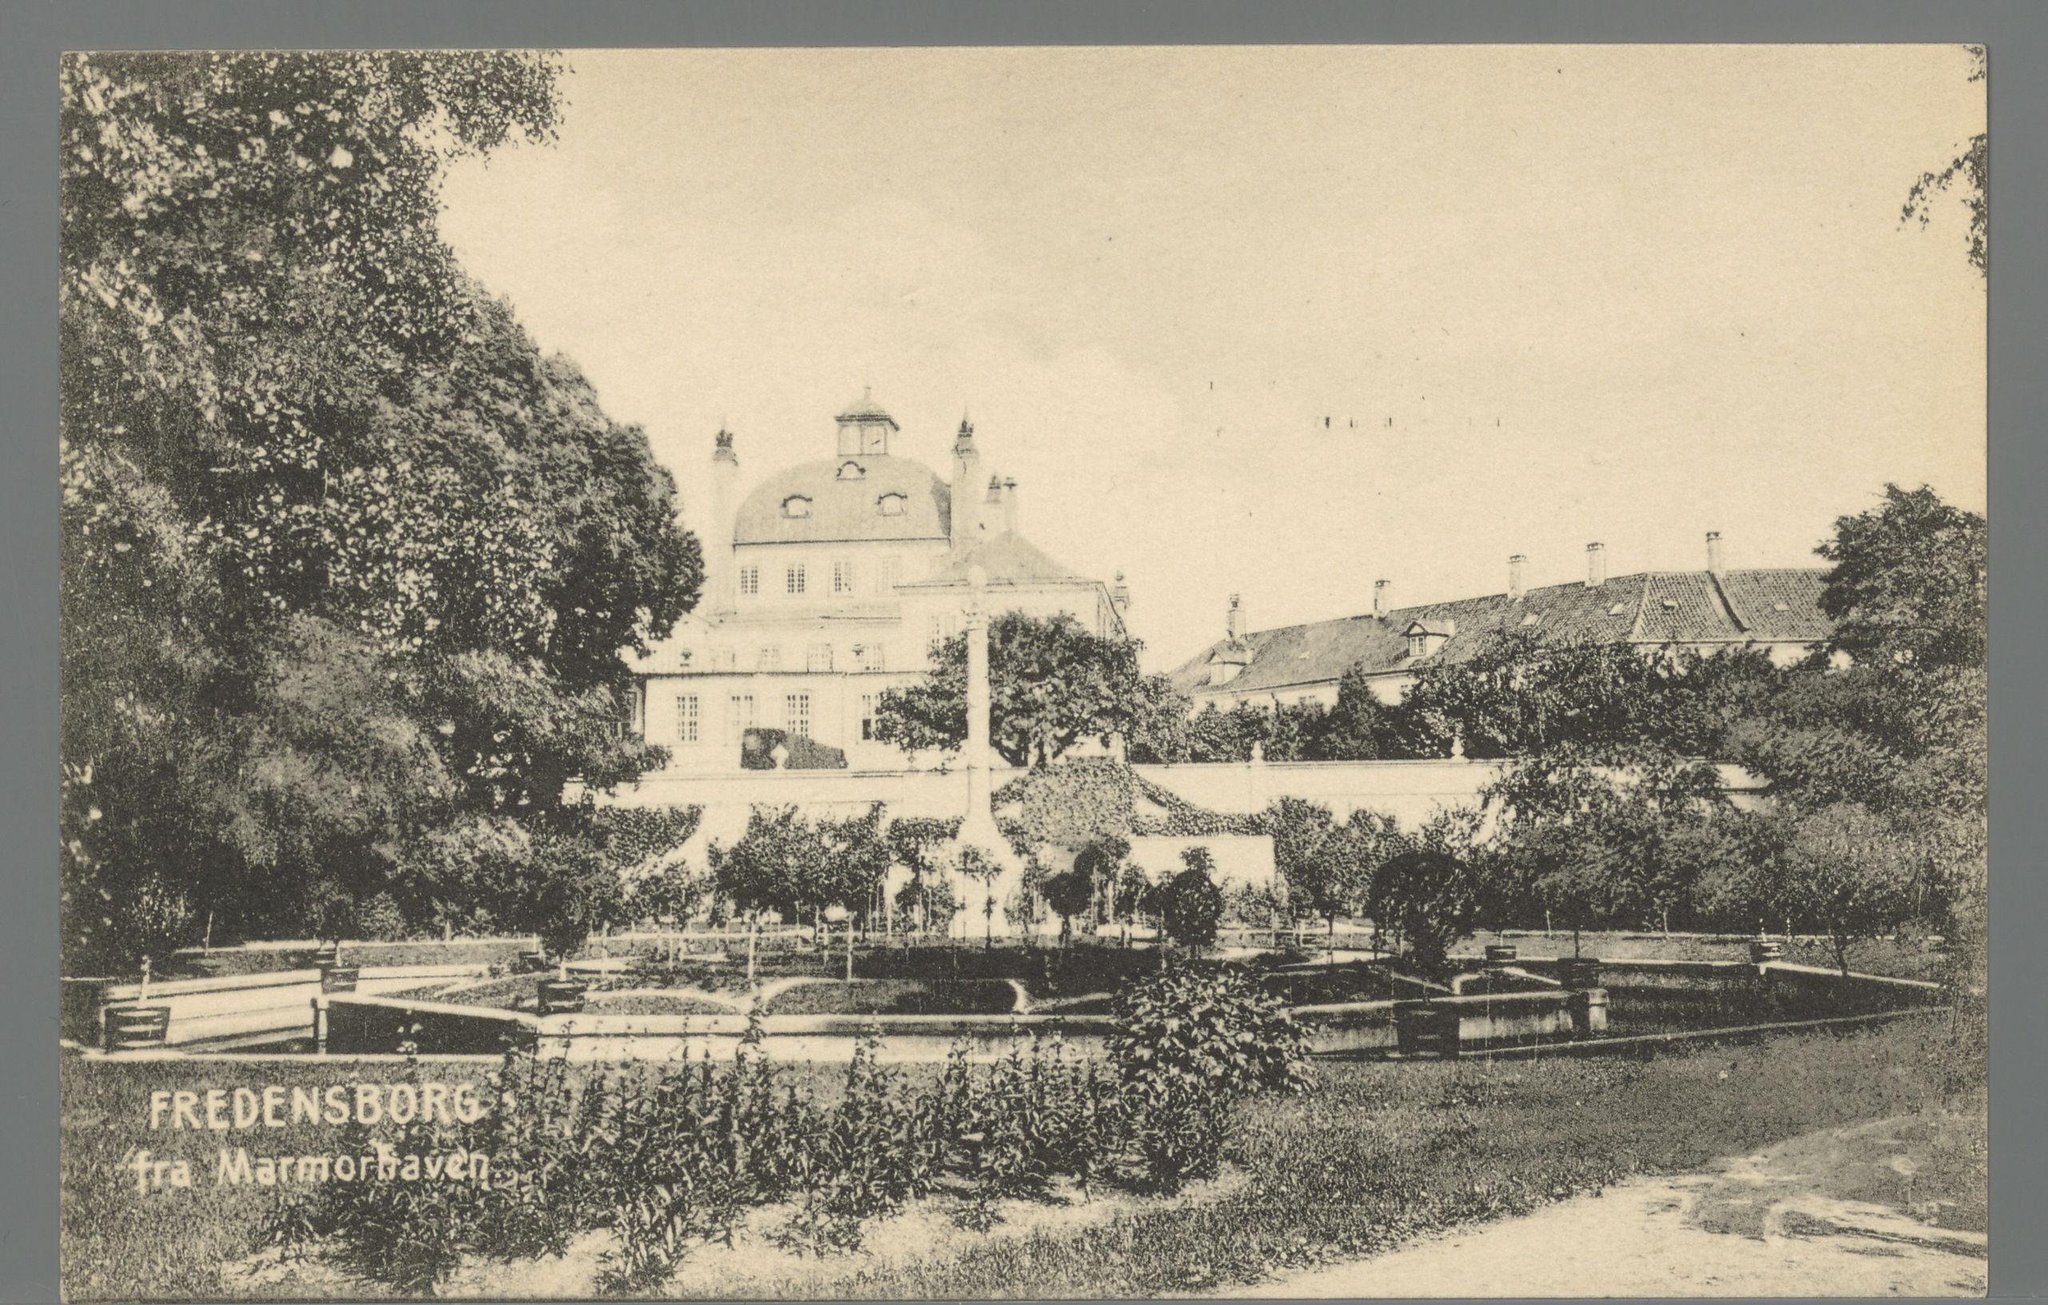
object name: photomechanical print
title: Fredensborg fra Marmorhaven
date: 1904-1925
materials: cardboard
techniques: photograph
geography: fredensborg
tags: palace, french or architectonic garden; formal garden